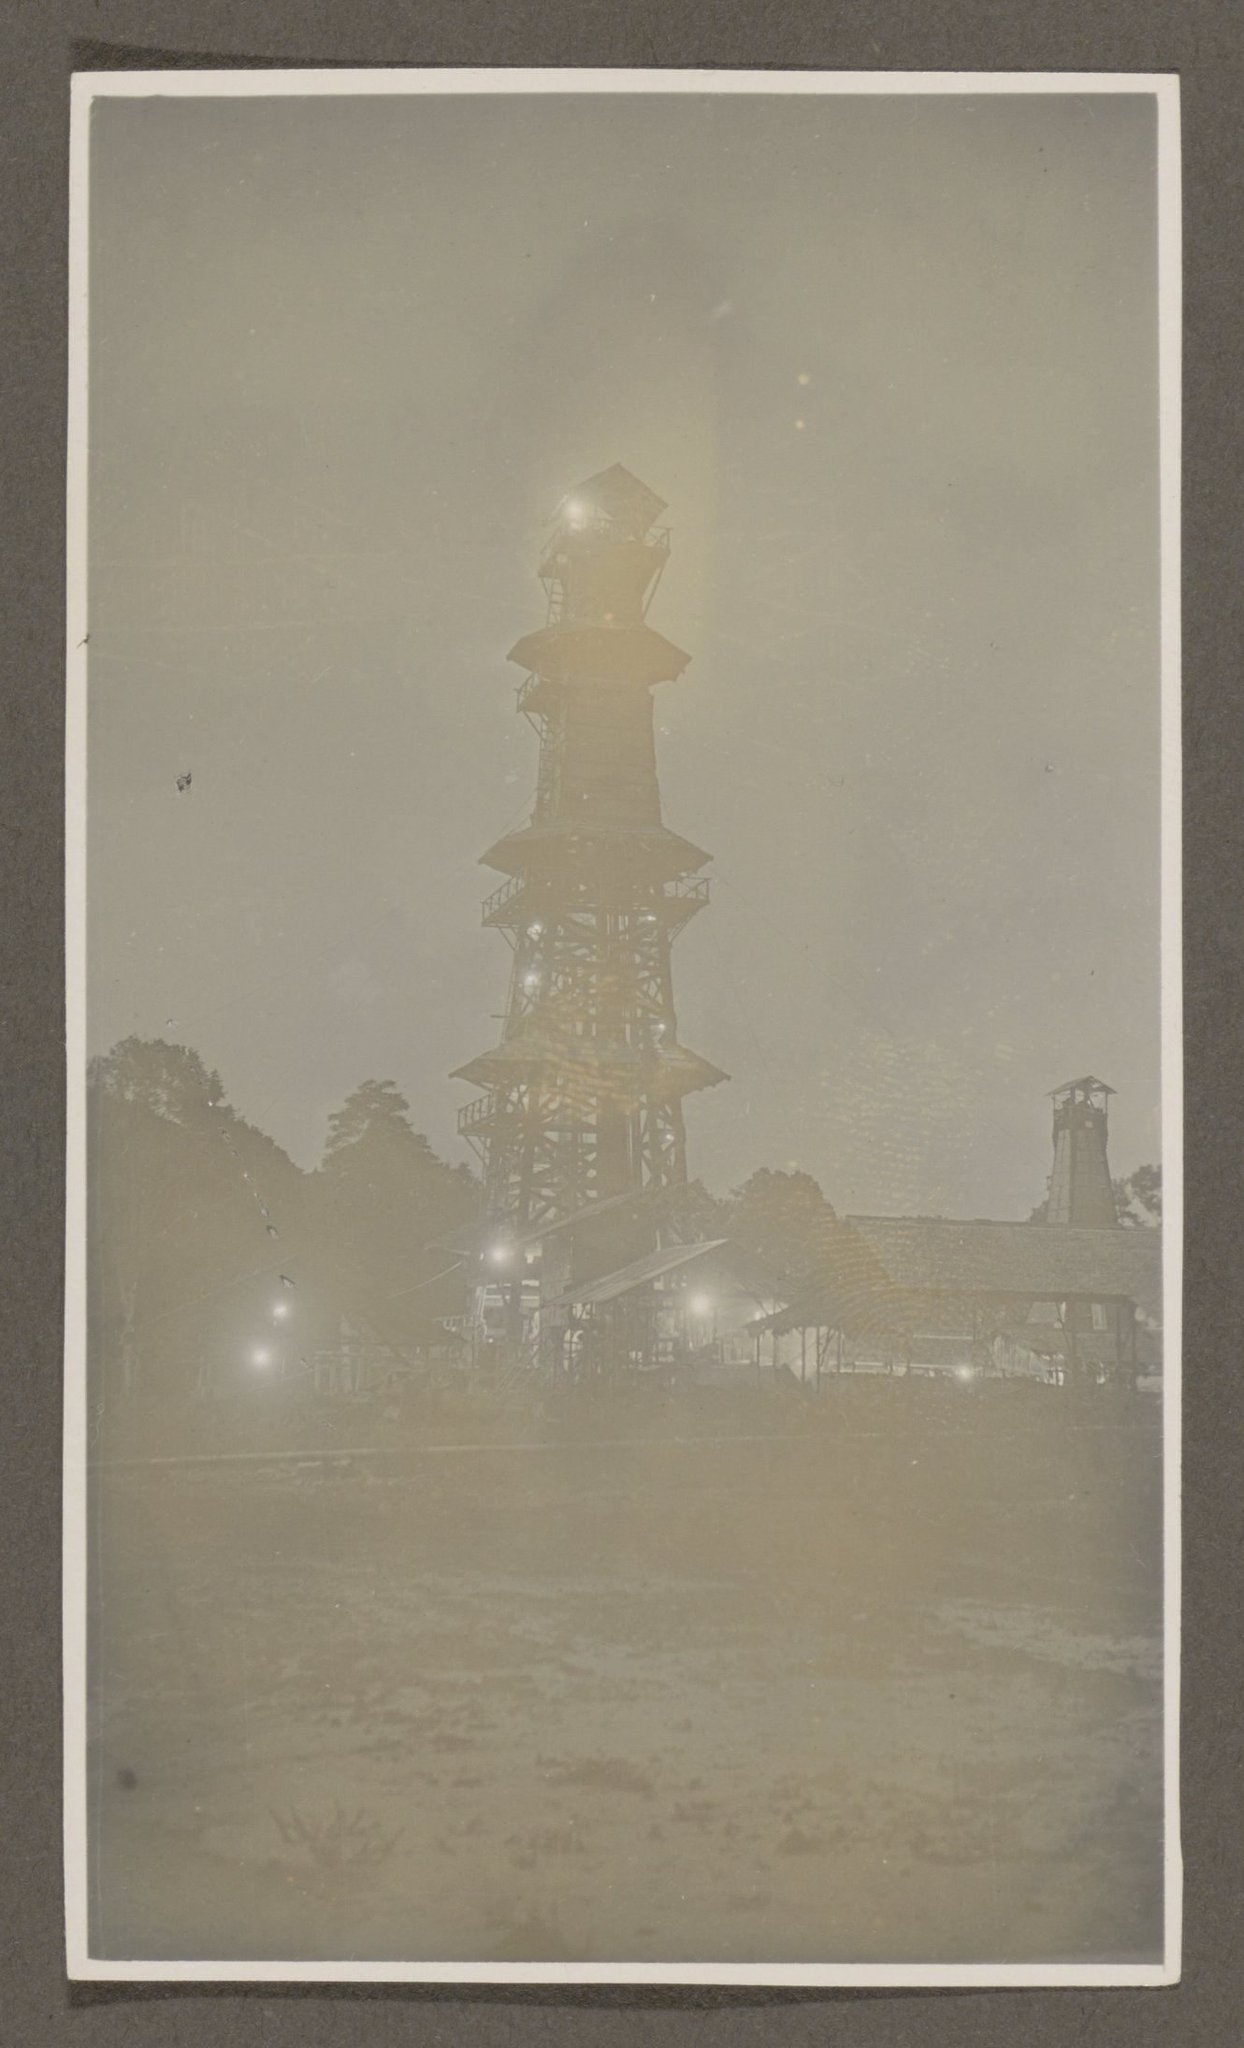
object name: photograph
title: Boortoren met verlichting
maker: Anonymous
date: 1920-1930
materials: photographic support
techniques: gelatin silver print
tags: machines, engines ~ crafts and industries, dutch east indies, the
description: Onderdeel van familiealbum Nederlands-Indië.